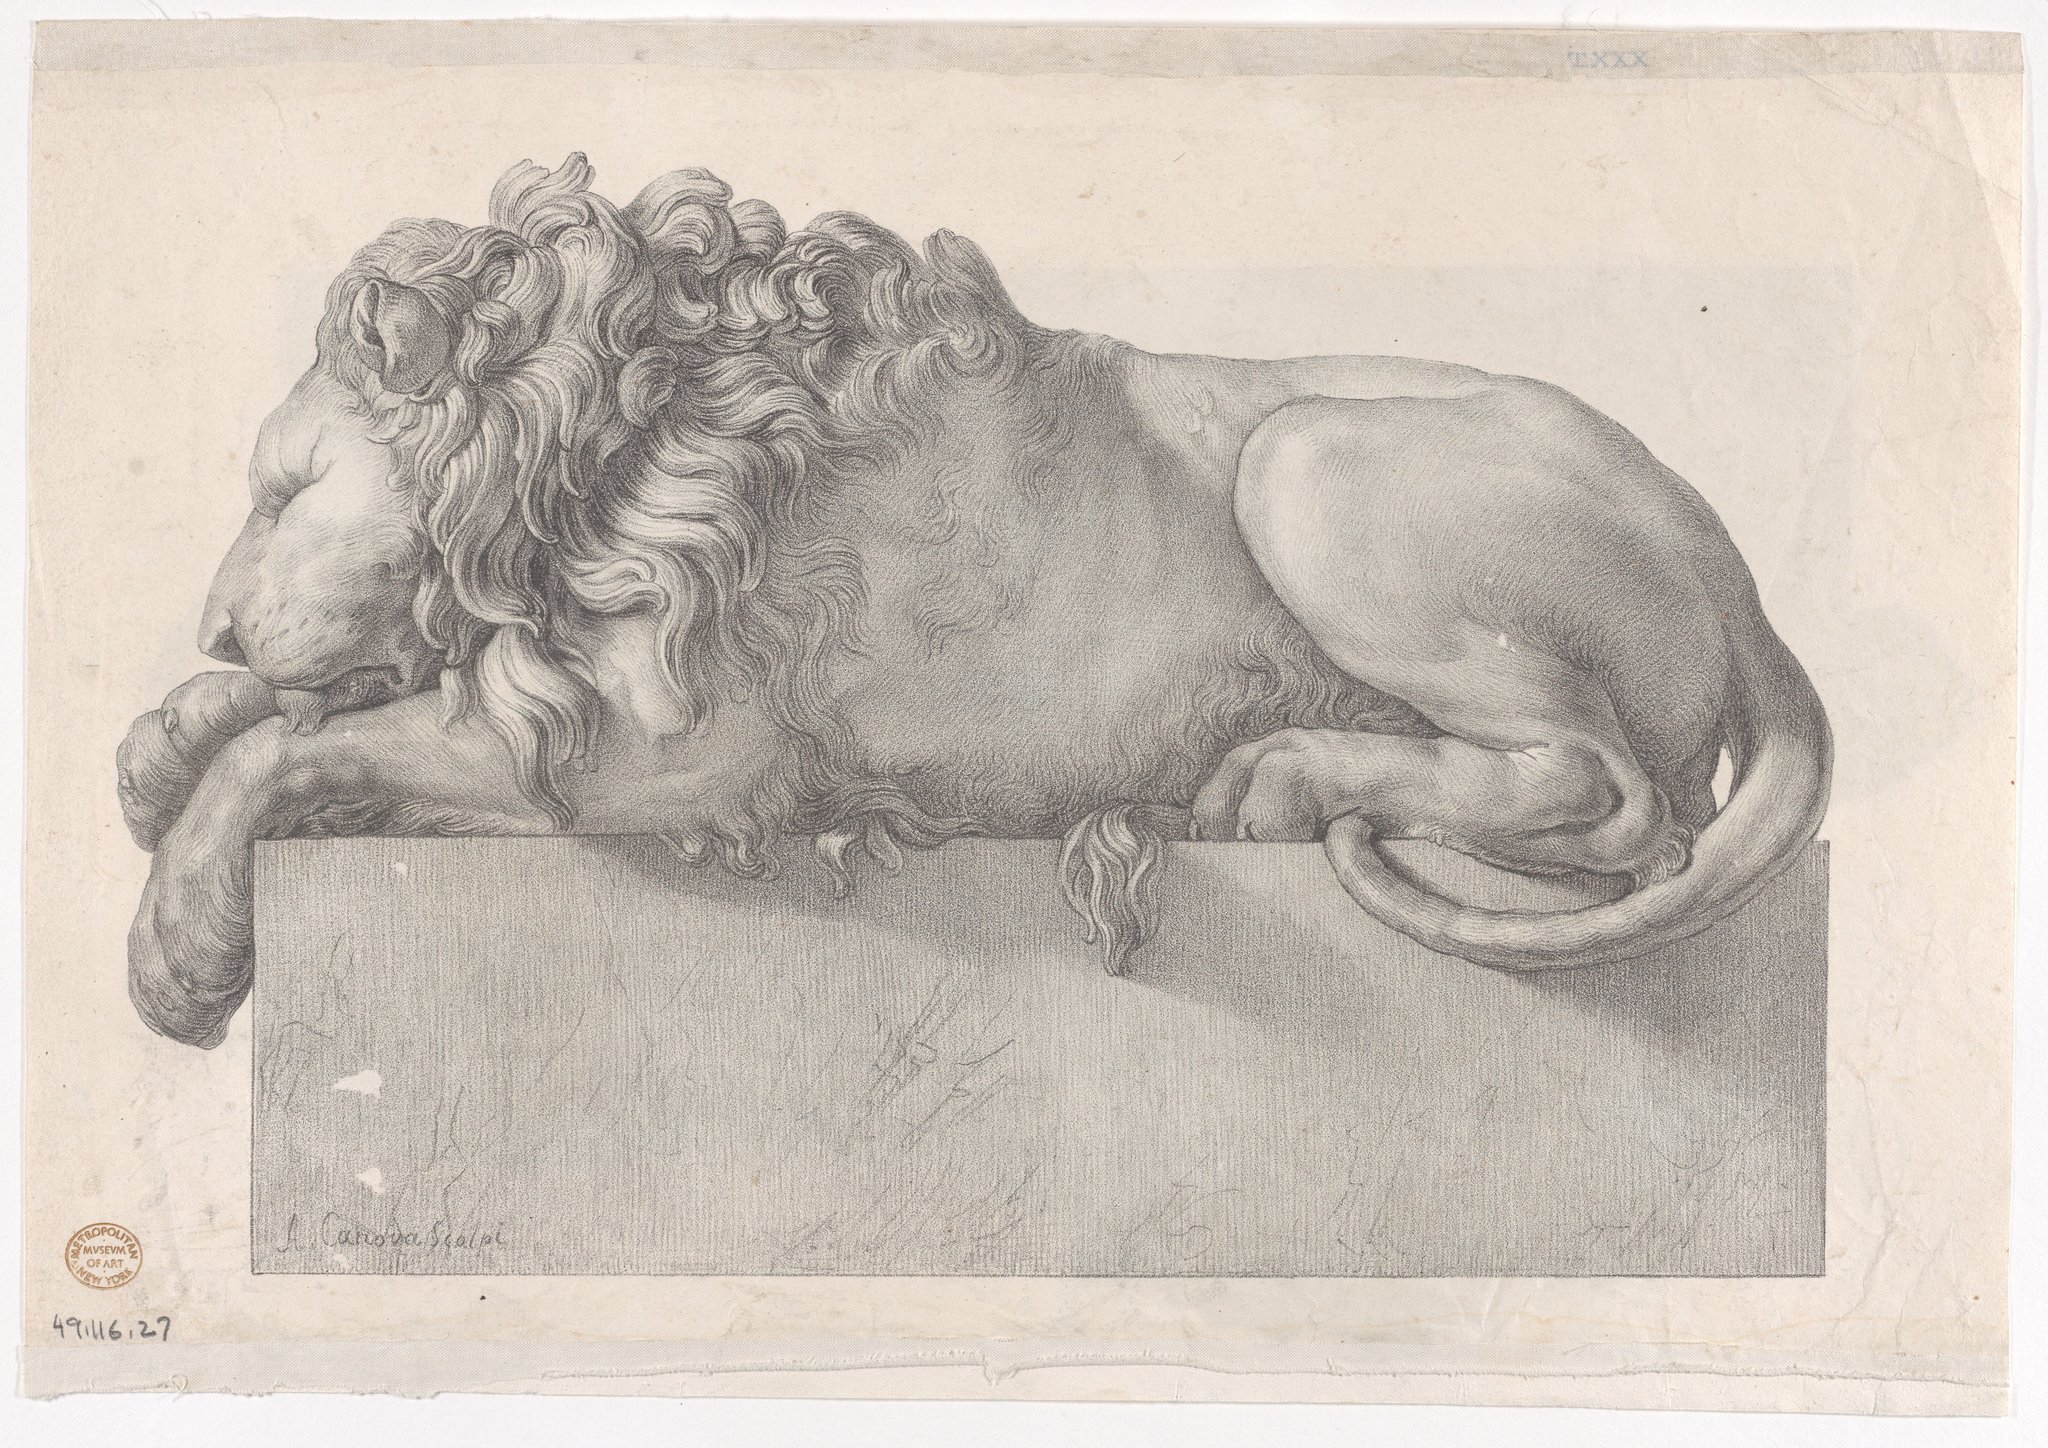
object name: print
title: Statue of a recumbent lion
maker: Anonymous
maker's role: artist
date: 1825-1900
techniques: lithograph, printing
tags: lions